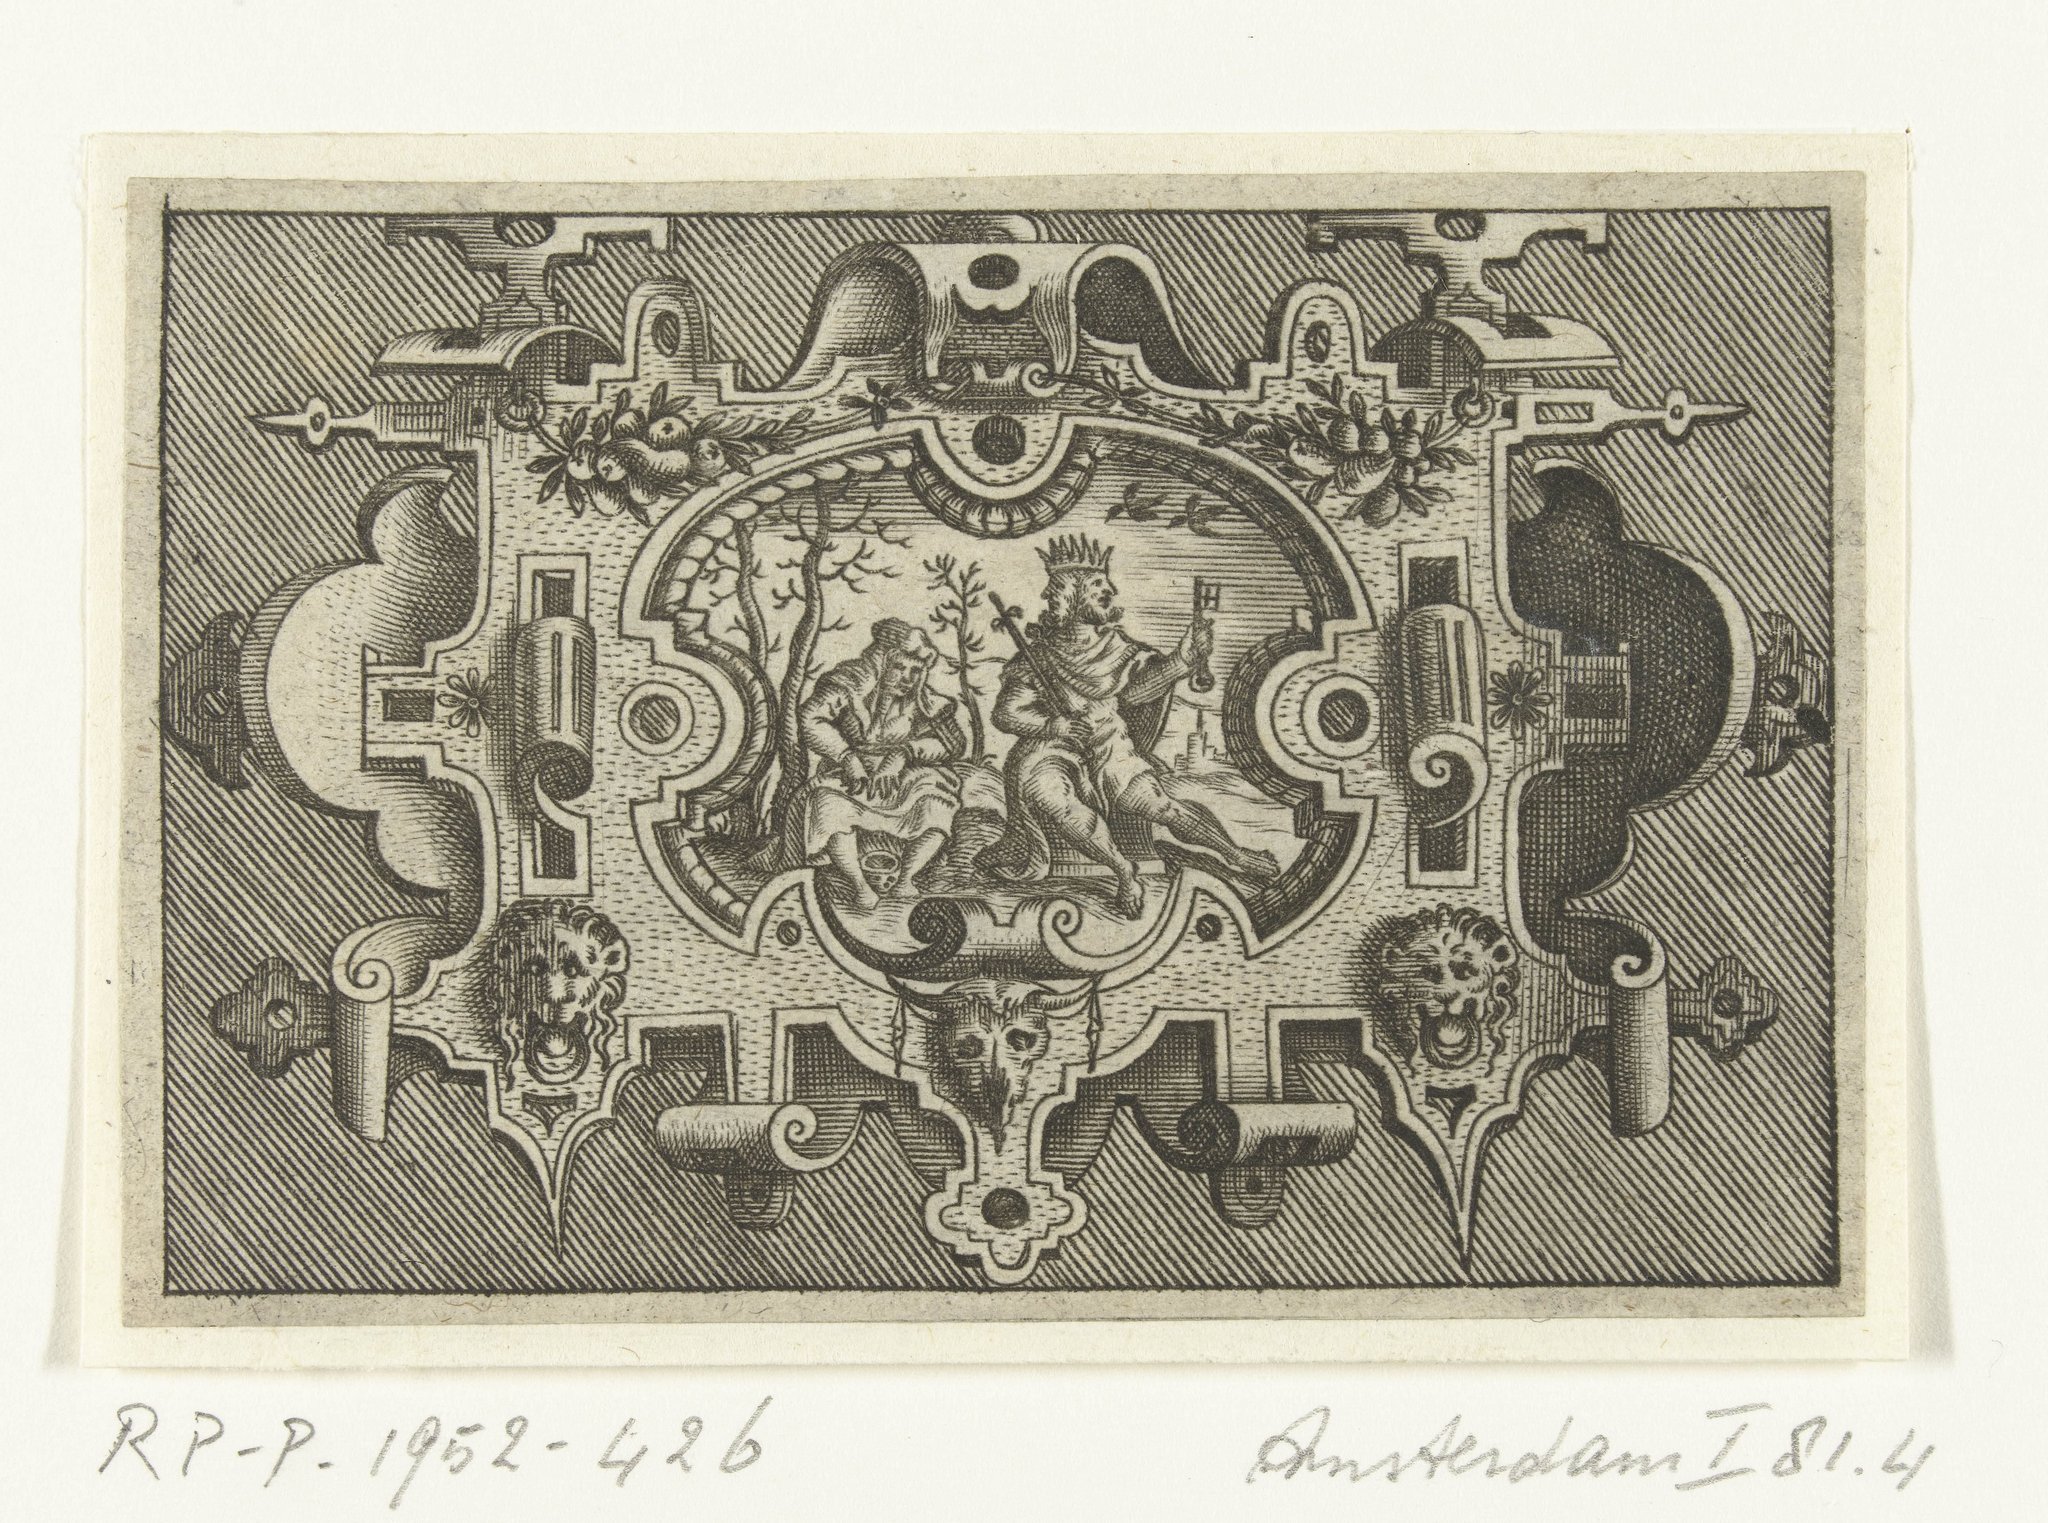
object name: ornament print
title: Compertimentorum quod vocant multiplex genus…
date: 1566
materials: paper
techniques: engraving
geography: netherlands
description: Voorstellingen van de vier jaargetijden: de winter (Janus). Blad uit serie bestaande uit een titelblad en 15 van de 16 bladen met cartouches met bijbelse en mythologische voorstellingen in een omlijsting van rolwerk en grotesken.